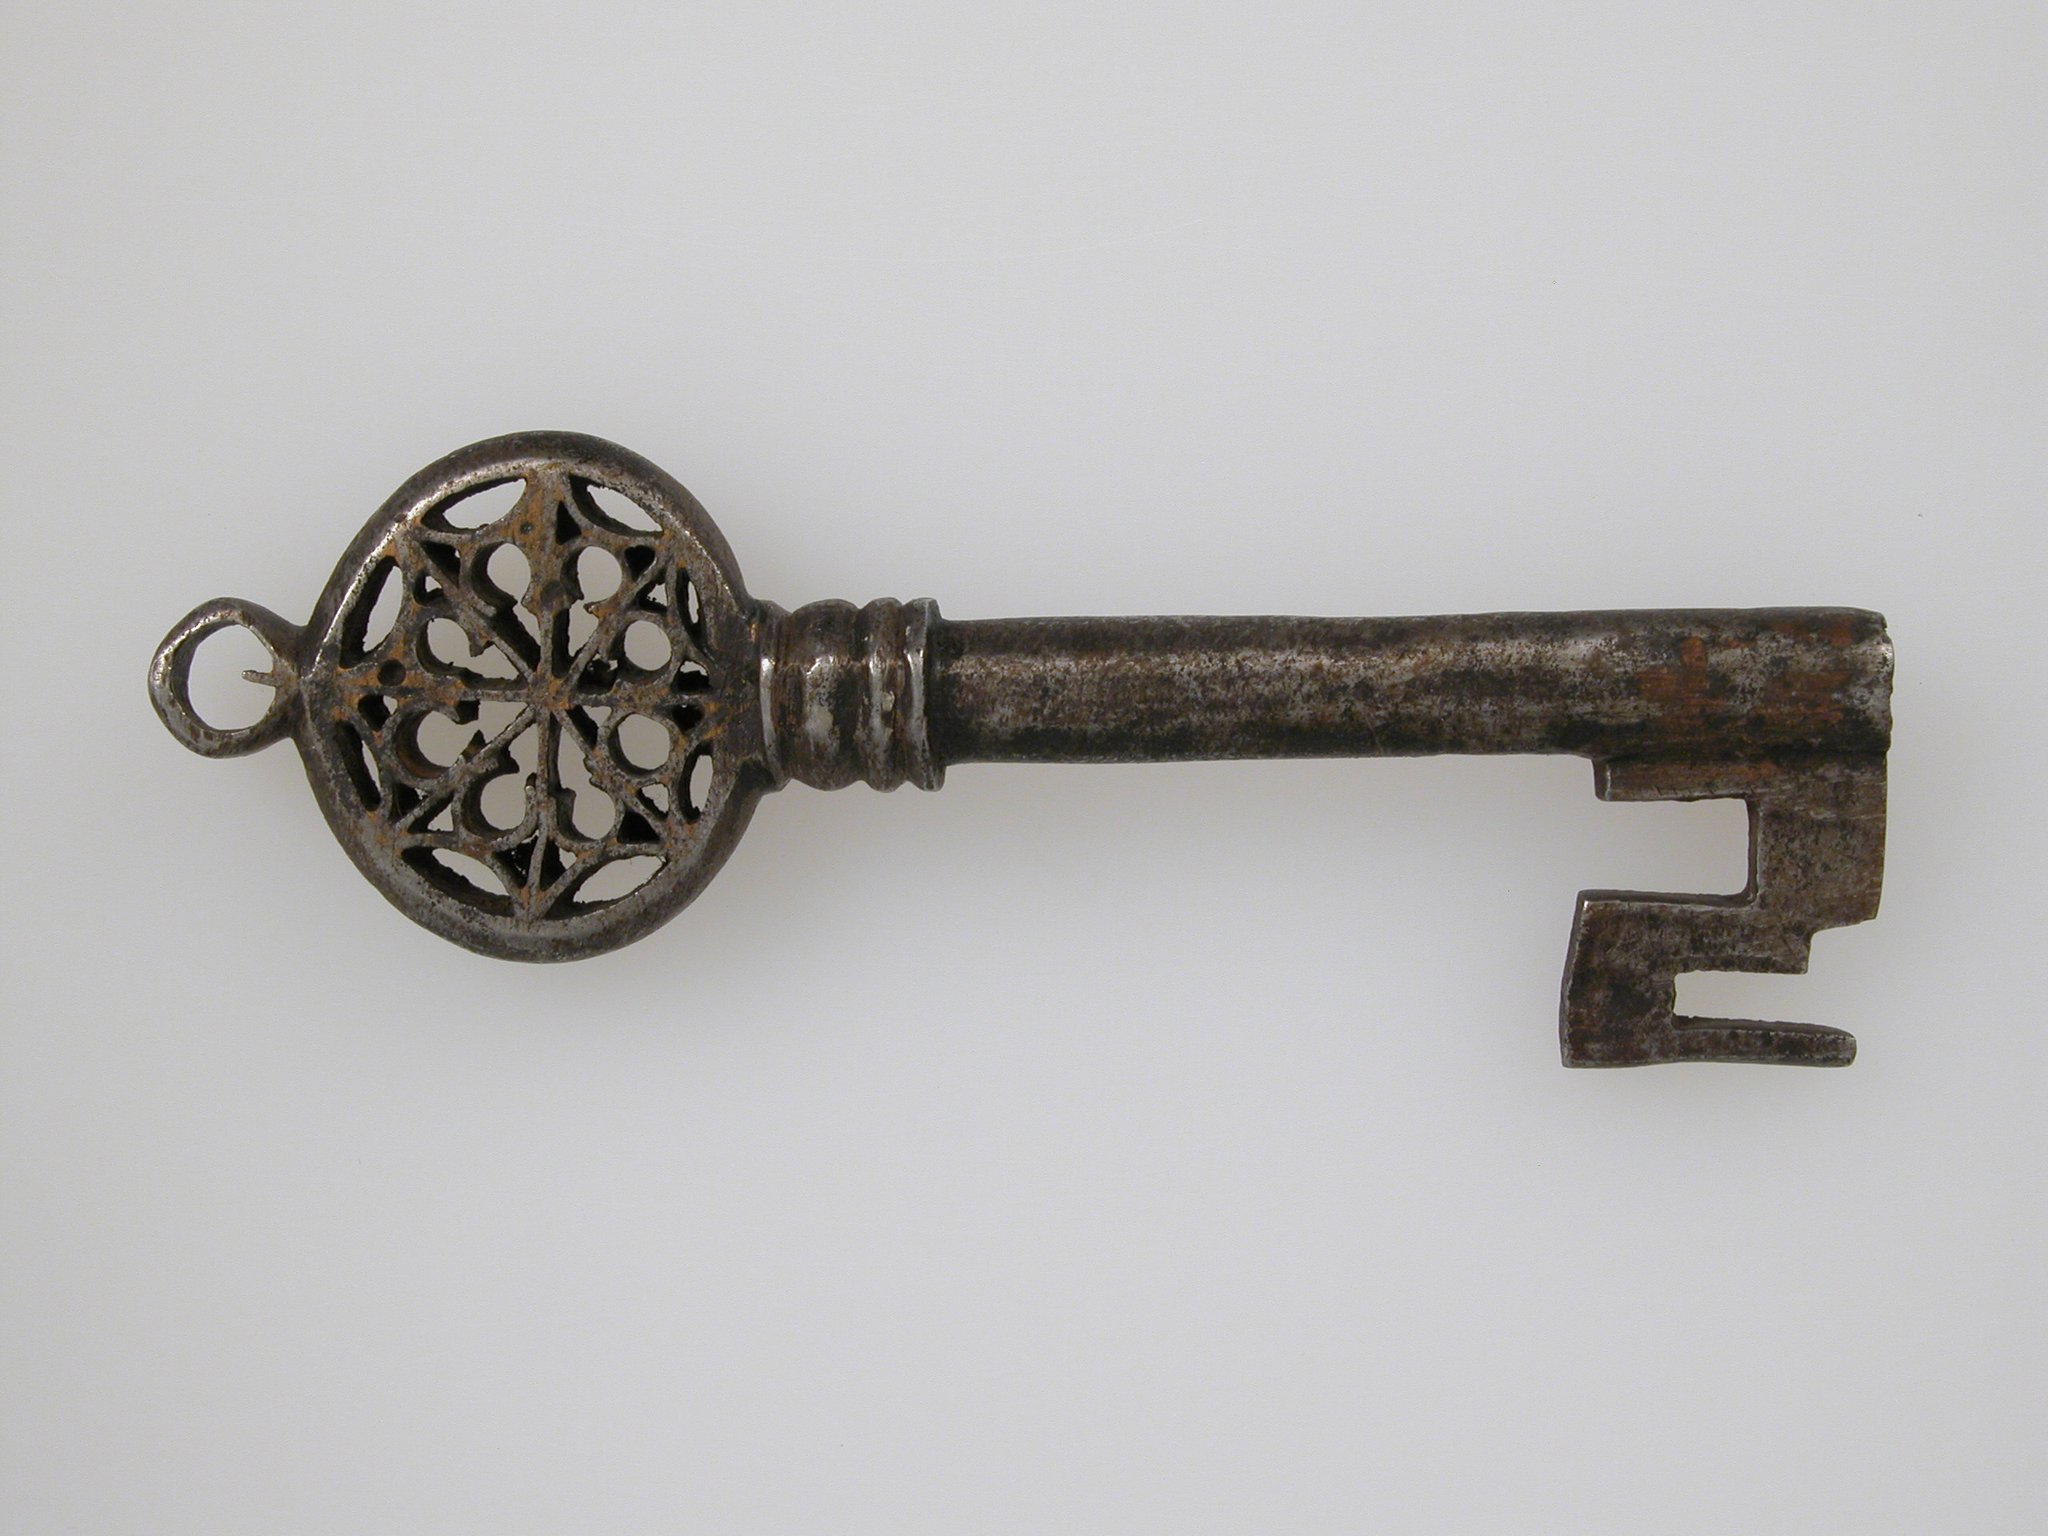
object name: key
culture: german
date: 1401-1500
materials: iron